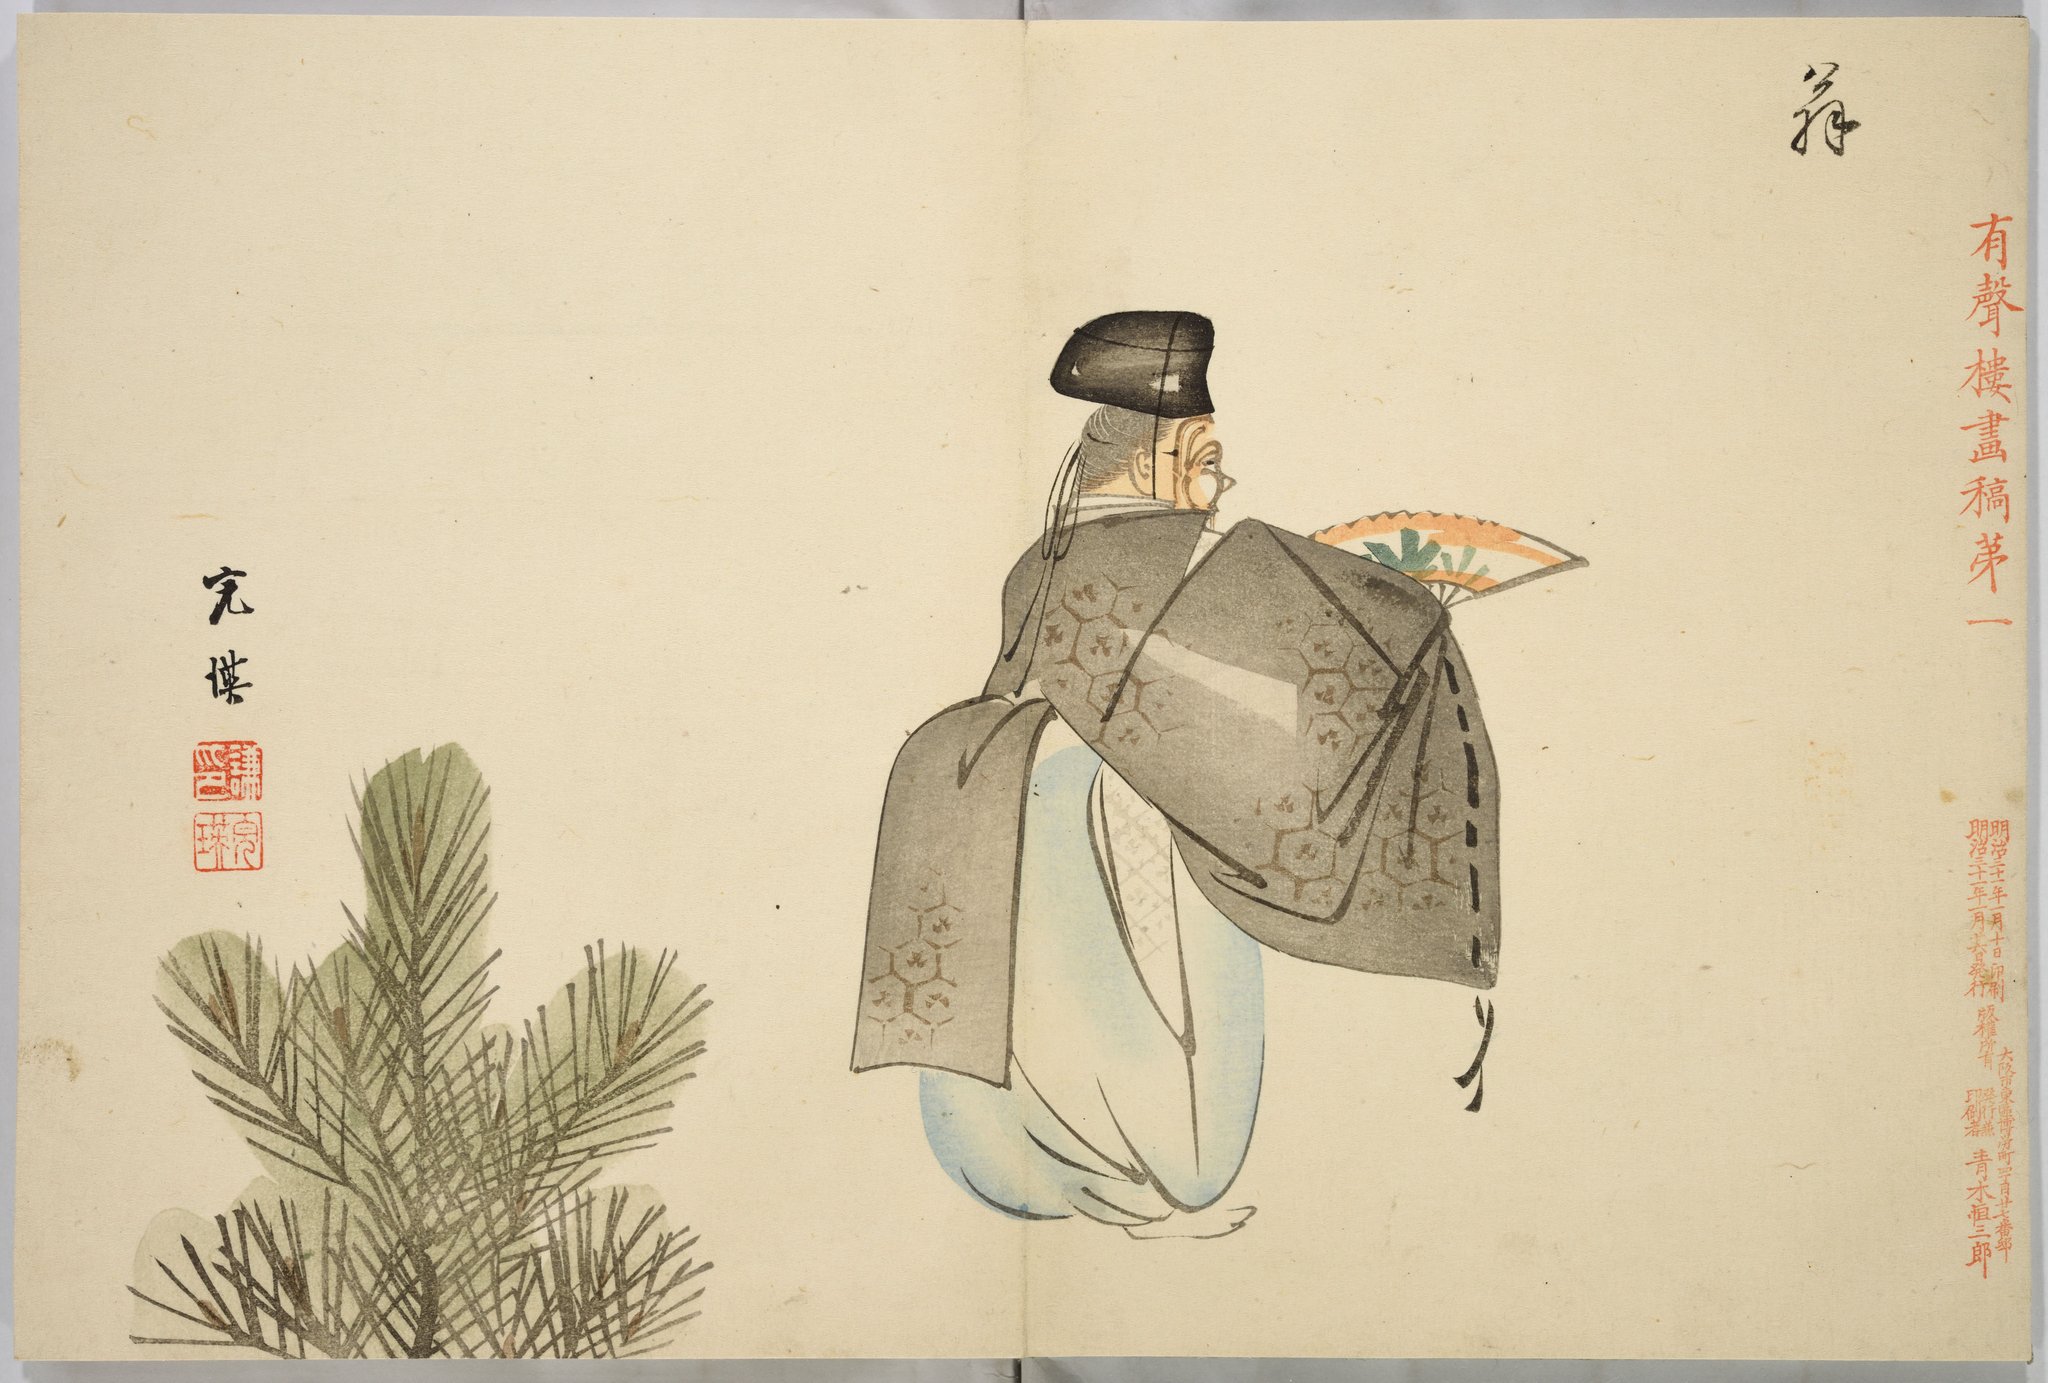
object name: illustrated book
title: Yuseiro's Picture Album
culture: japanese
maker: nishiyama hōen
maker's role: artist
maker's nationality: japanese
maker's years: 1807-1867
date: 1898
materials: ink, paper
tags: fans,men